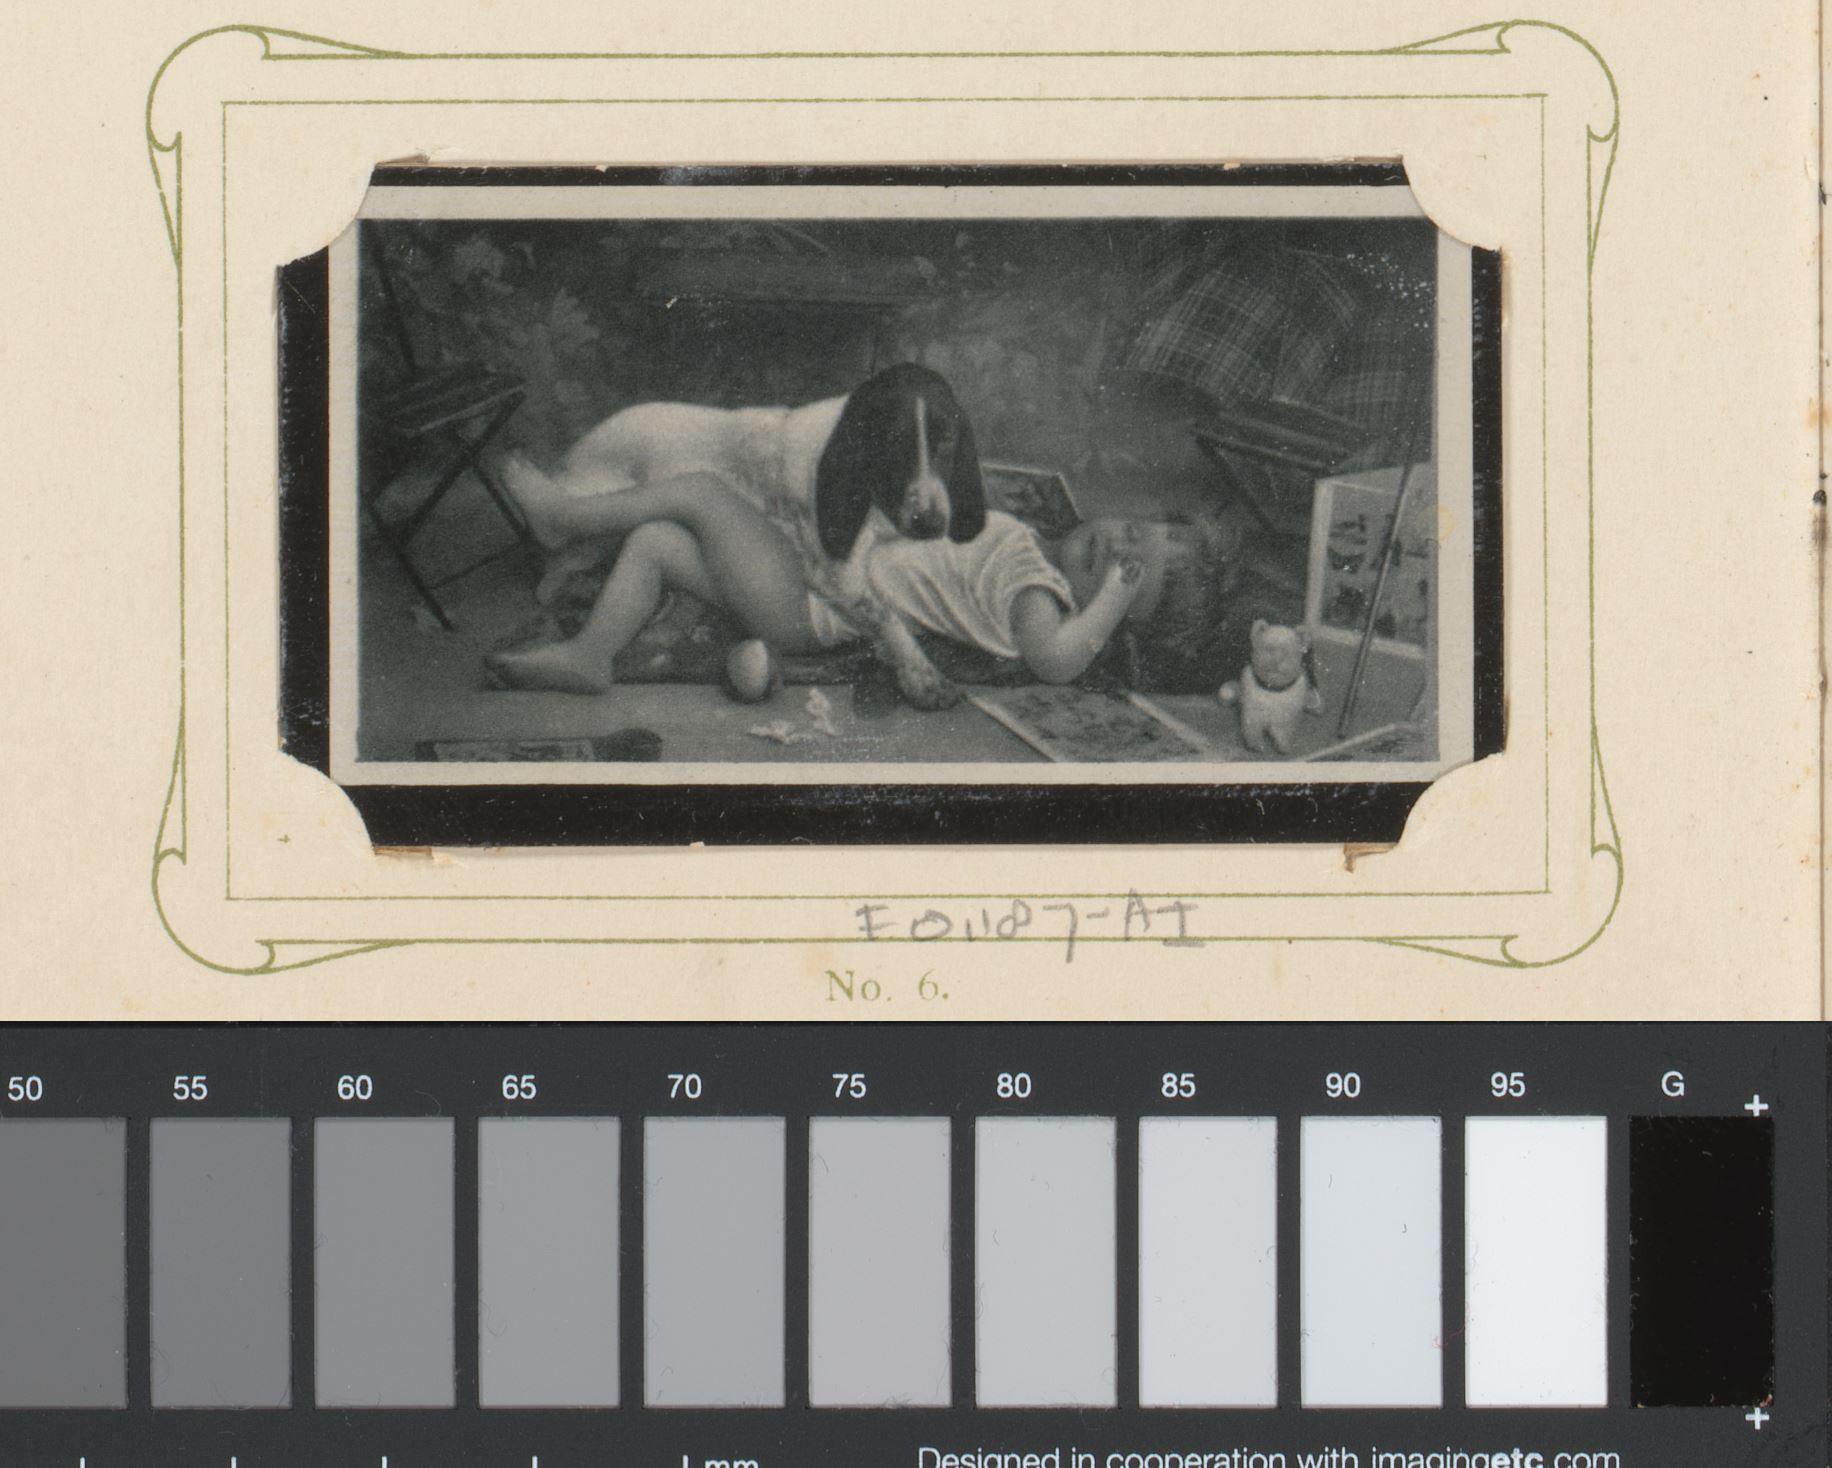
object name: photomechanical print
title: Rustend kind en hond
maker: Anonymous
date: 1905-1906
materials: paper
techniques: photograph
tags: tot, toddler ~ the ages of man, resting, dog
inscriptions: inscription: ‘No. 6./ De hond en het kind rusten van hun arbeid.’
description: Deze prent maakt deel uit van een album.